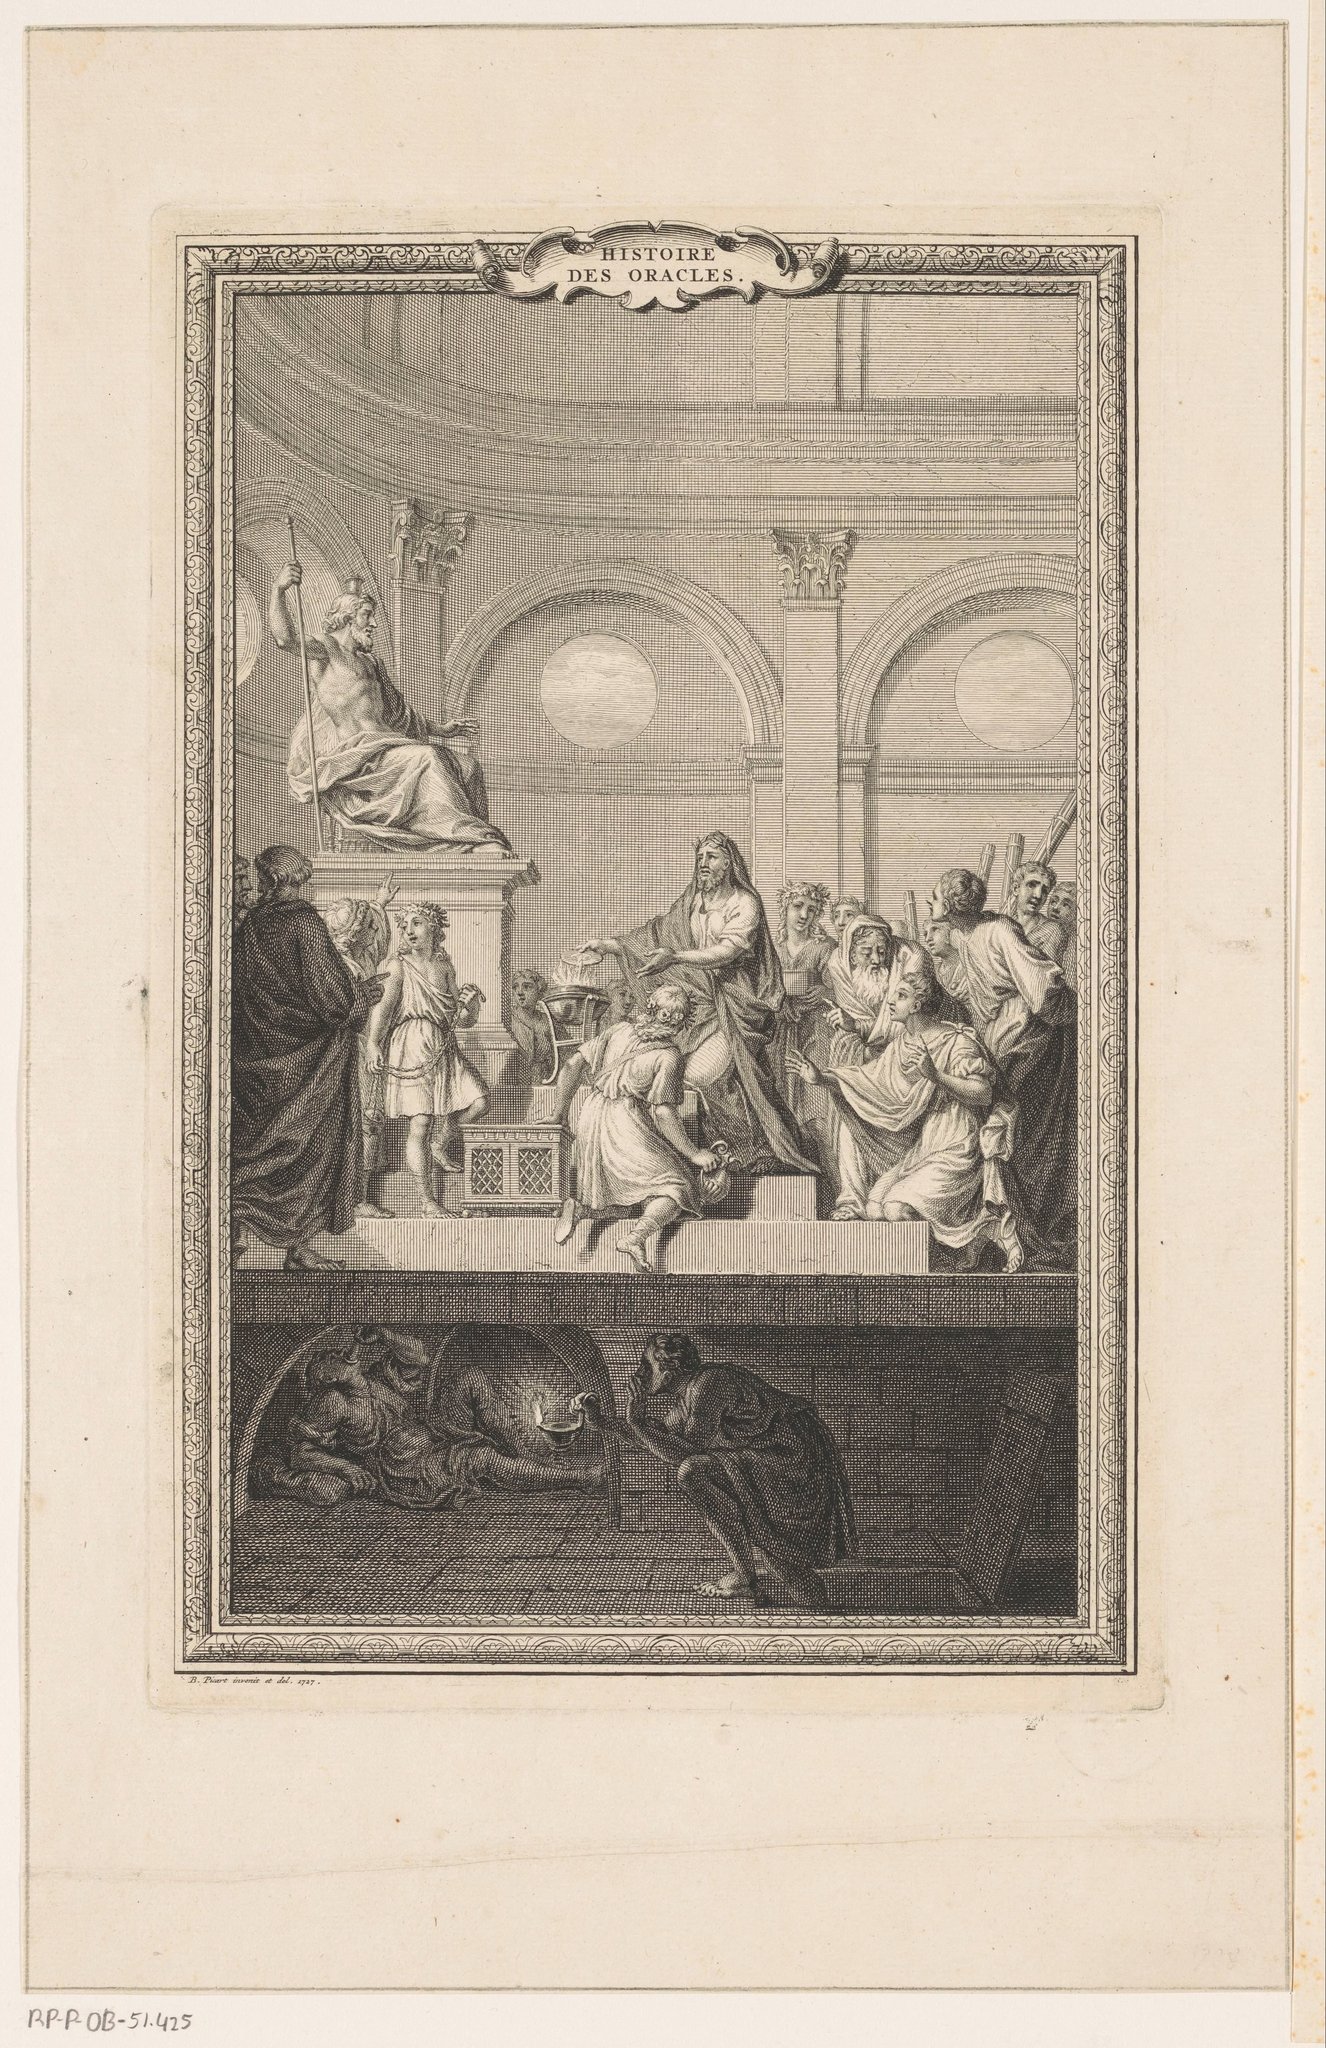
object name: book illustration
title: Een orakel in een tempel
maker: bernard picart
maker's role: draughtsman, print maker, publisher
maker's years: 1673-1733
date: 1727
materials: paper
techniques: engraving, etching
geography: amsterdam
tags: tripod, sacrifice (+ variant), oracle ~ non-christian religions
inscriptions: collector's mark: Lugt 240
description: Gelovigen hebben zich verzameld in een tempel. Een orakel brengt een offer aan het cultusbeeld. Op de voorgrond sluipt een figuur met een brandende olielamp een kelder in. Daar ligt een man die uit een hoorn drinkt.